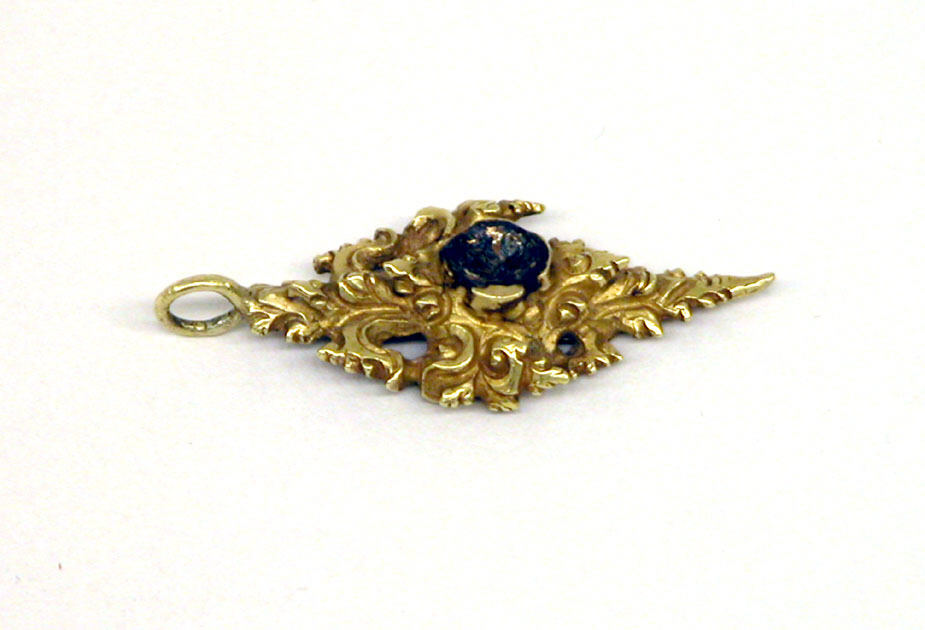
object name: pendant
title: Pendant with Inlaid Stones Surrounded by Foliate Motif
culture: indonesian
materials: gold, stone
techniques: inlay